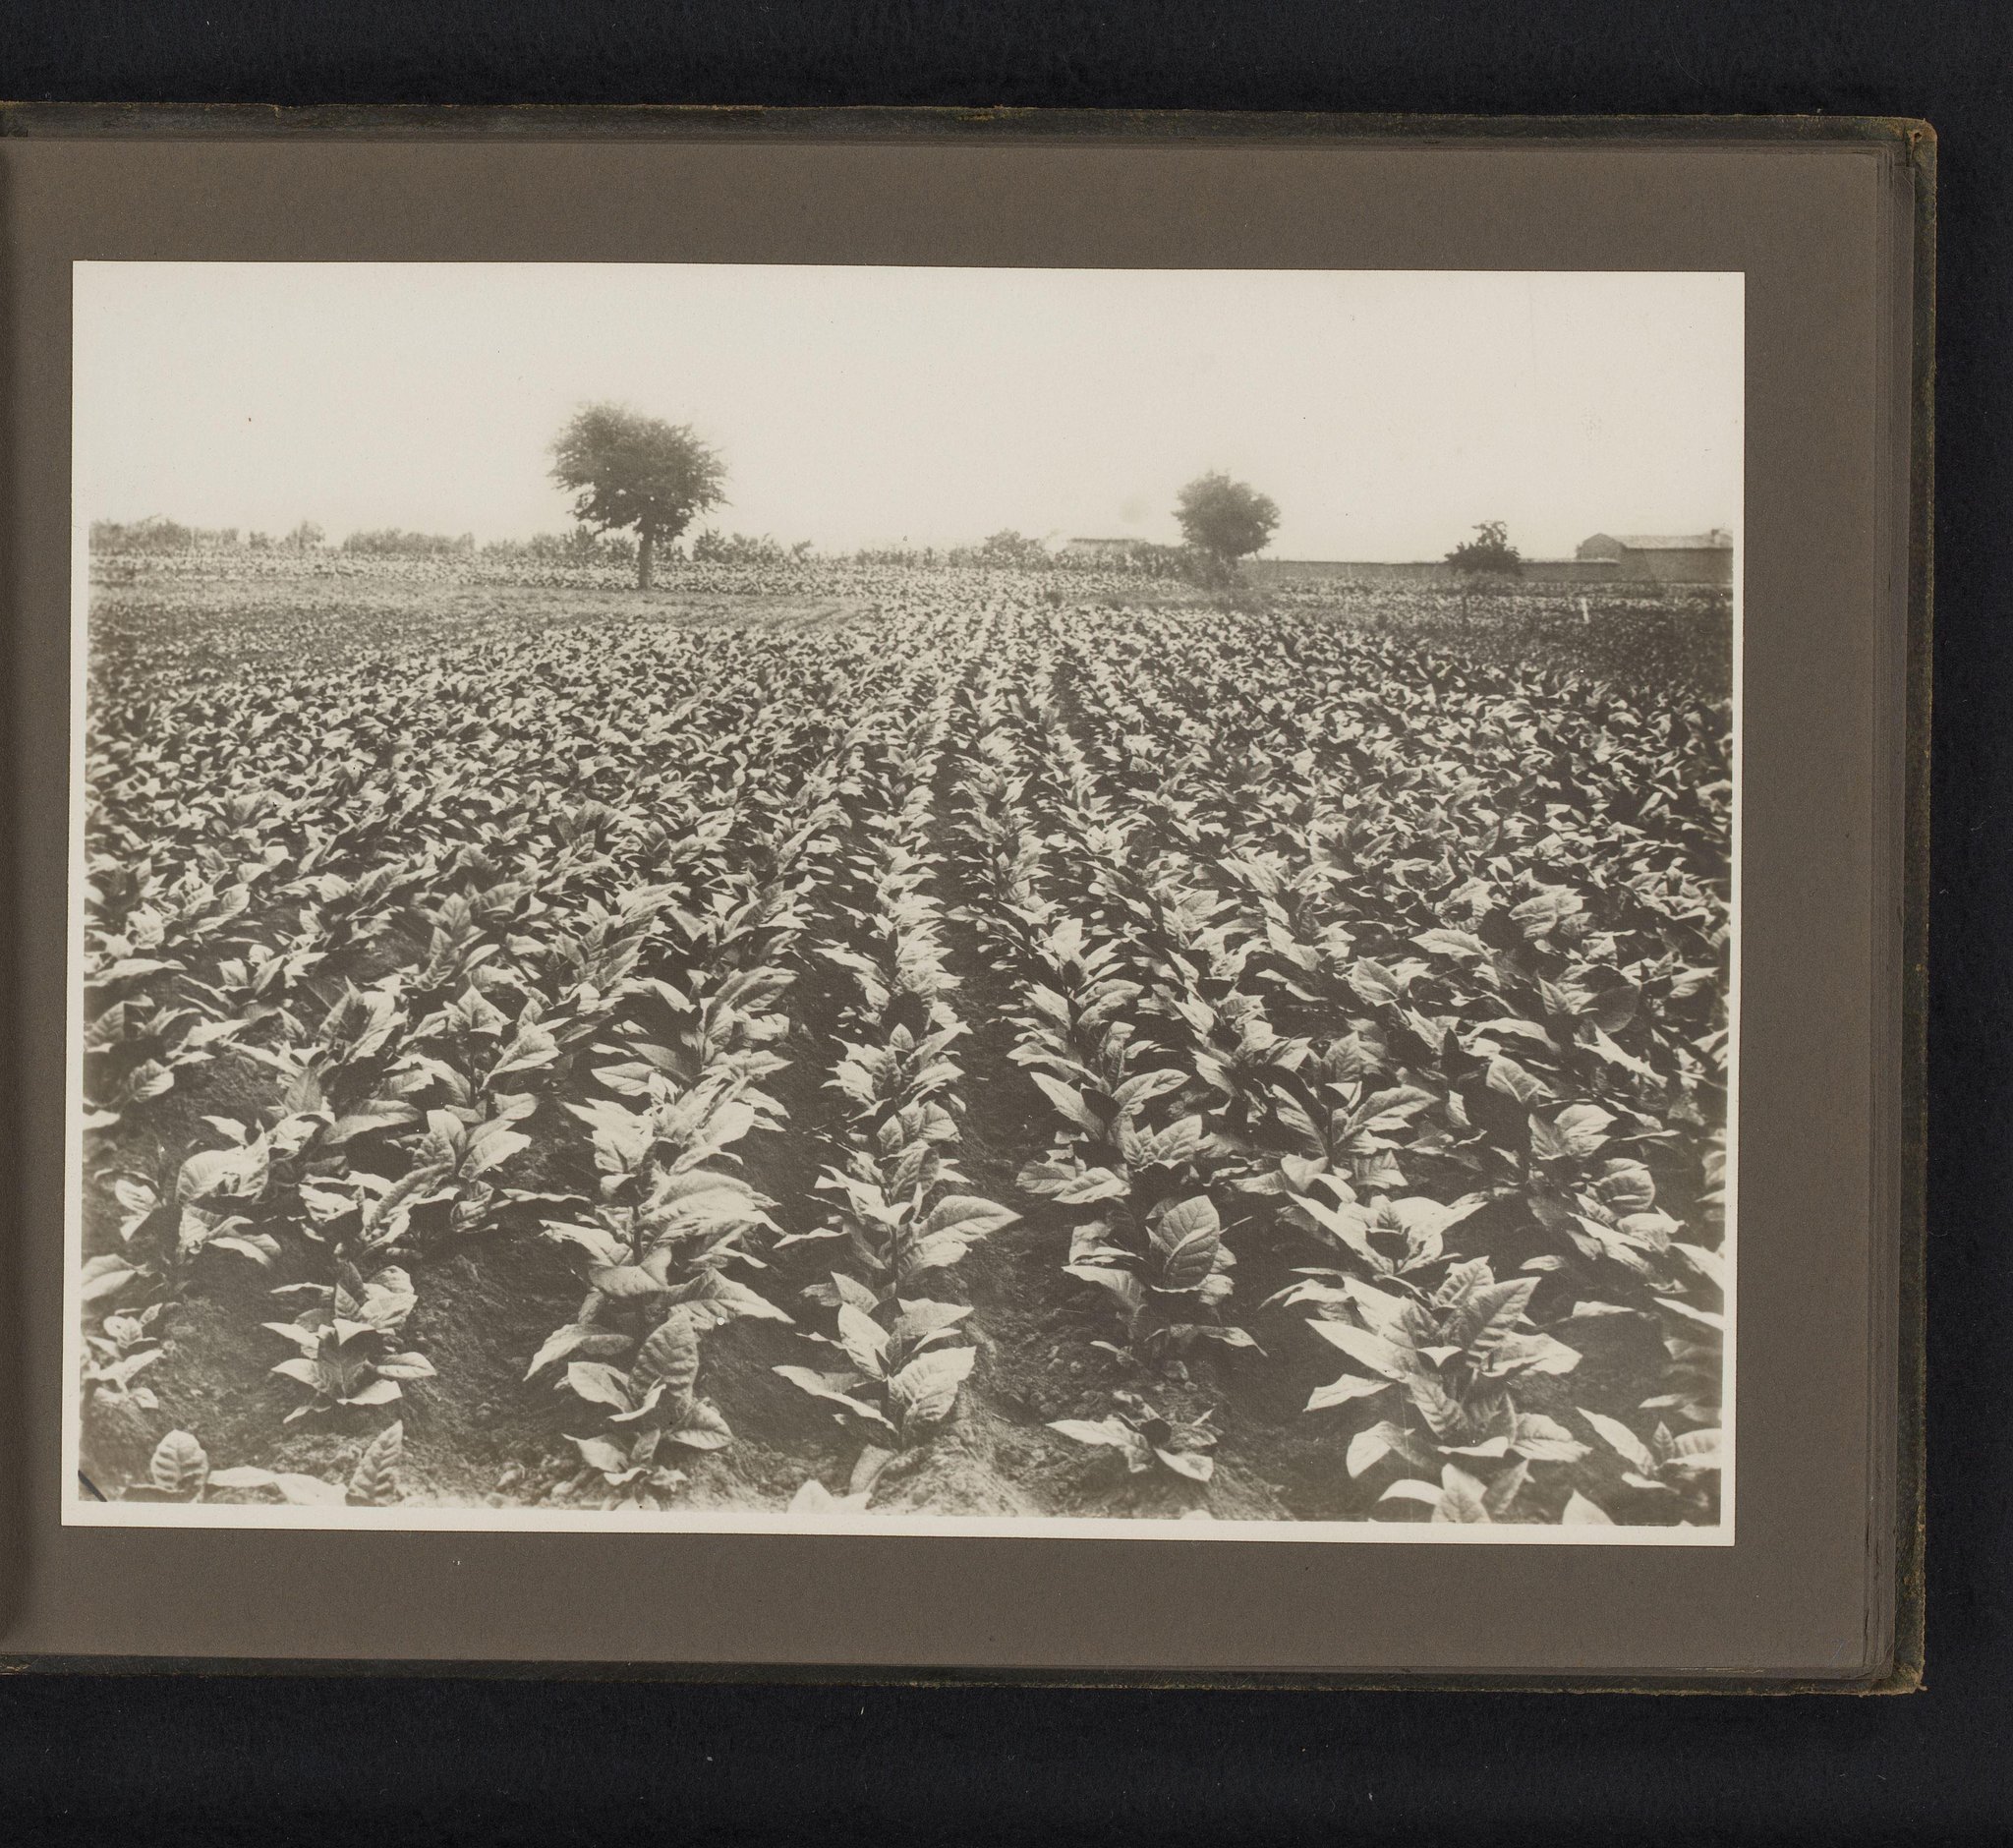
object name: album leaf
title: Rijen tabaksplanten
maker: Anonymous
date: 1925-1928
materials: cardboard, photographic support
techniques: gelatin silver print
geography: bulgaria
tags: eugen wachenheimer, (non-fruit) products of plants or trees: tobacco, cultivation ~ agriculture, tobacco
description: Een akker met rijen tabaksplanten. Onderdeel van het fotoalbum voor Eugen Wachenheimer bij zijn afscheid als directeur van het filiaal van de Deutsche Bank in Sofia, december 1928.